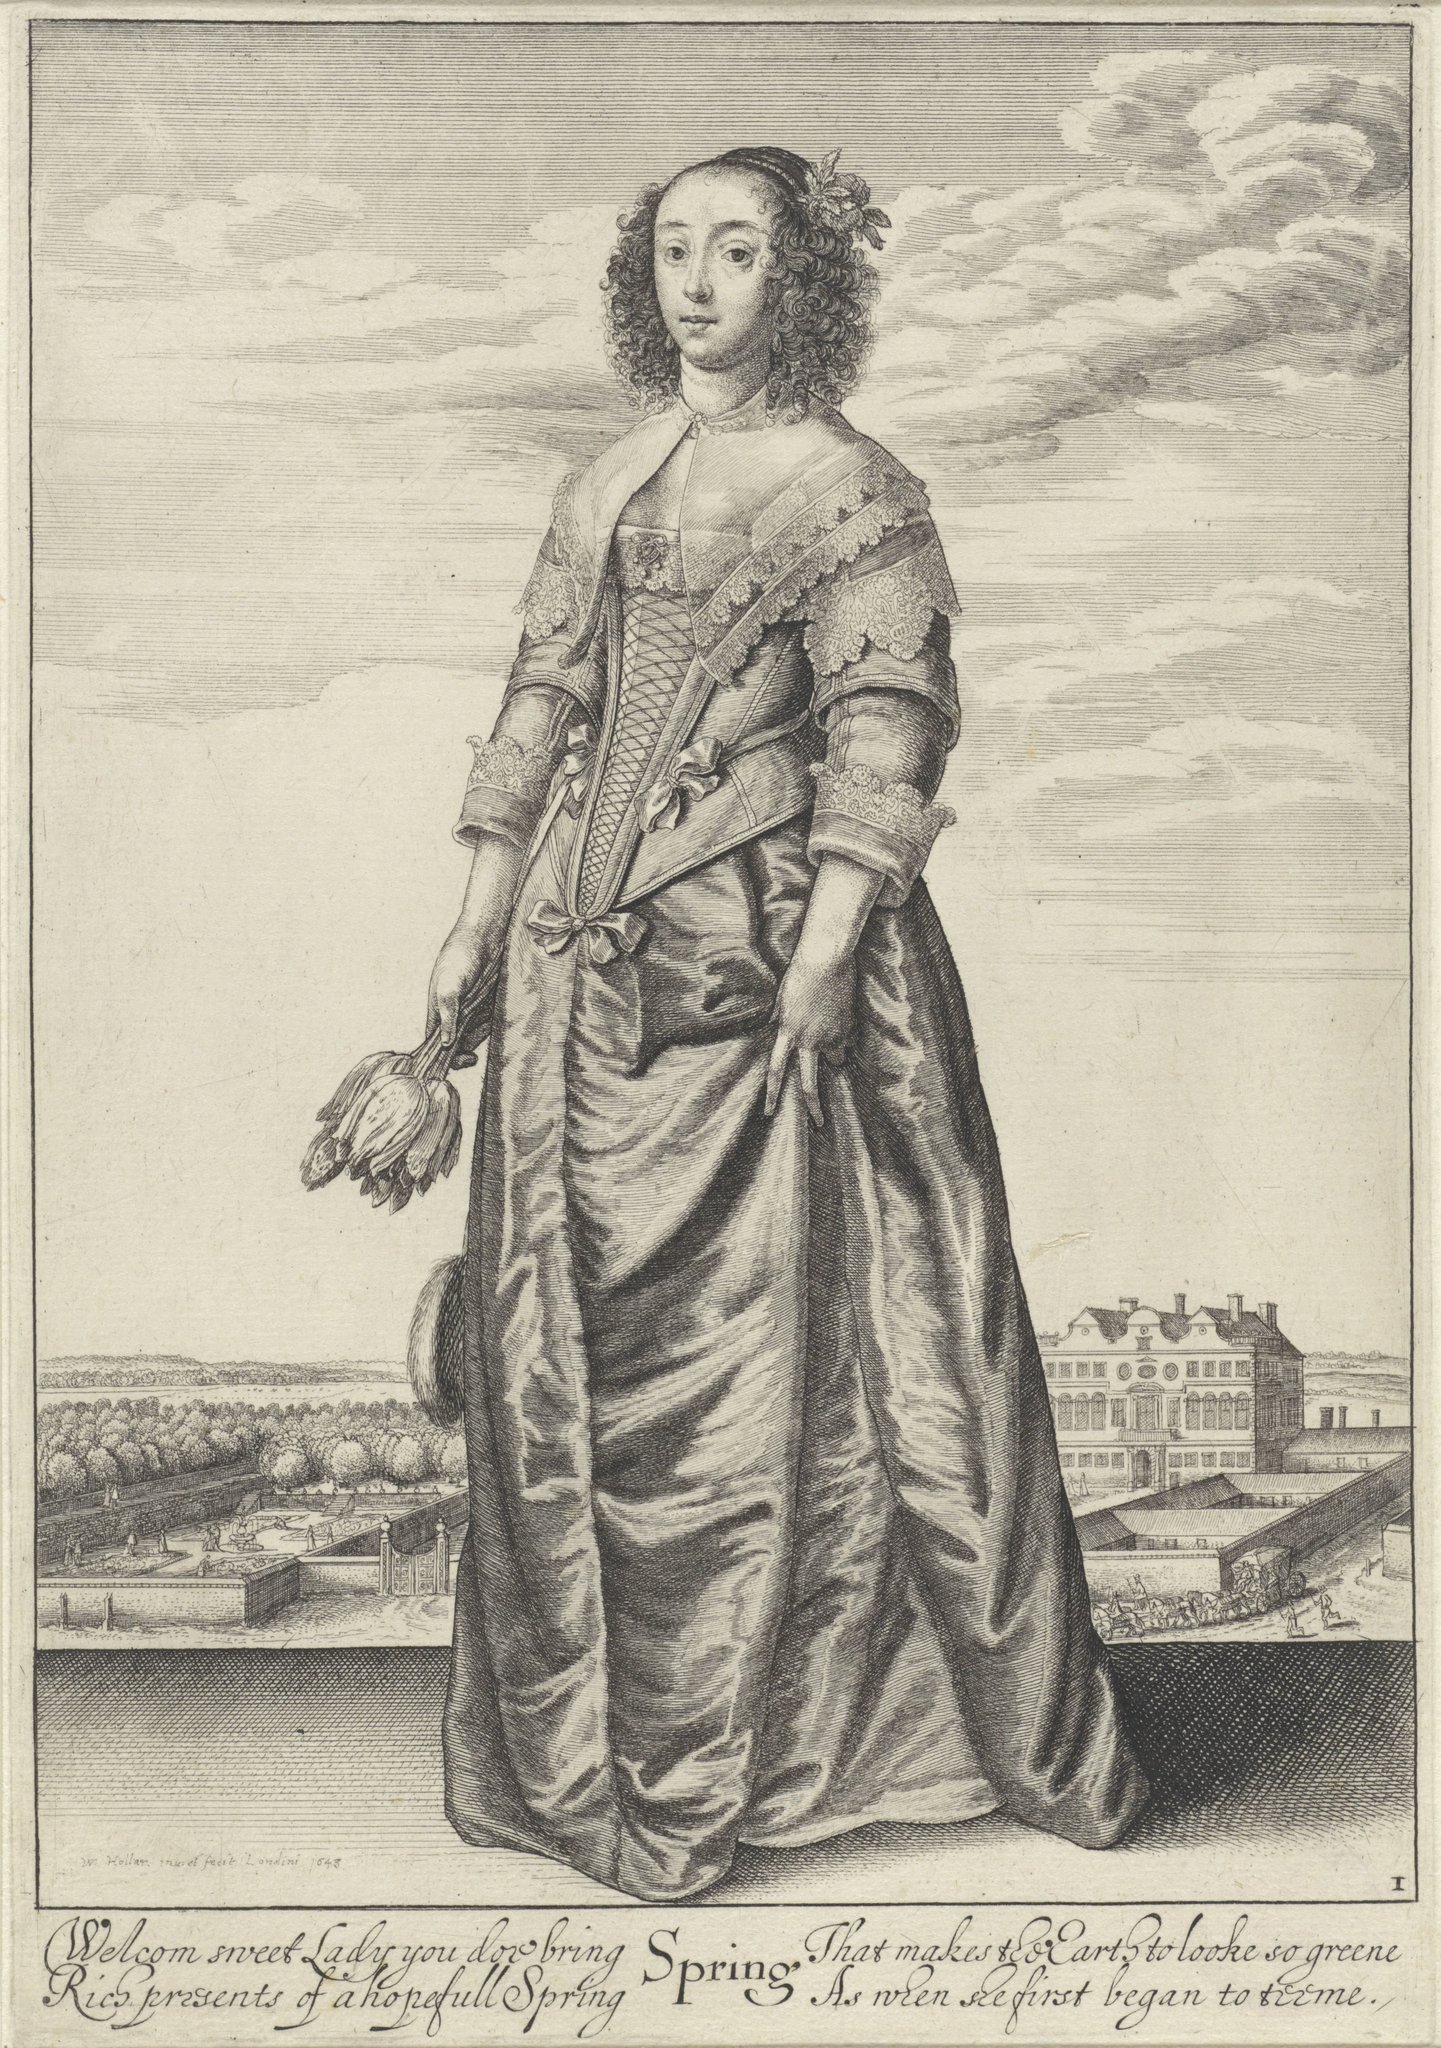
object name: costume print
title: Spring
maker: wenceslaus hollar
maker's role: draughtsman, print maker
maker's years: 1607-1677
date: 1643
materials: paper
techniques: etching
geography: london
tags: alatheia talbot (gravin van arundel), bow (ornamental part of clothing) (+ women's clothes), spring, 'ver'; 'primavera' (ripa), fashion plates, skirt (+ women's clothes), sleeves: cuffs (+ women's clothes), dress, gown (+ women's clothes), fan (+ women's clothes), flowers: tulip, piece of clothing covering the breast or décolleté (fichu) (+ women's clothes), sleeves (+ women's clothes), country-house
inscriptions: collector's mark: Lugt 240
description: Two years after producing his half-length Spring (adjacent), Hollar also published a full-length version. The large vase is missing this time. In the left background some visitors stroll around a formal garden with rectangular flowerbeds. In the caption Spring is addressed as the bearer of copious gifts.